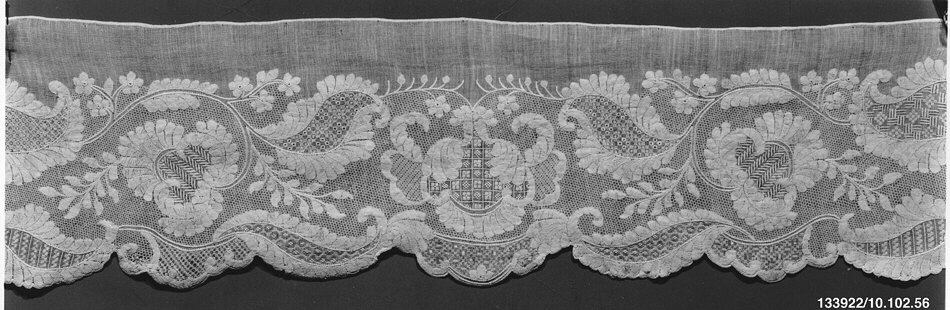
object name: fragment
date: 1701-1800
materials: linen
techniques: embroidery